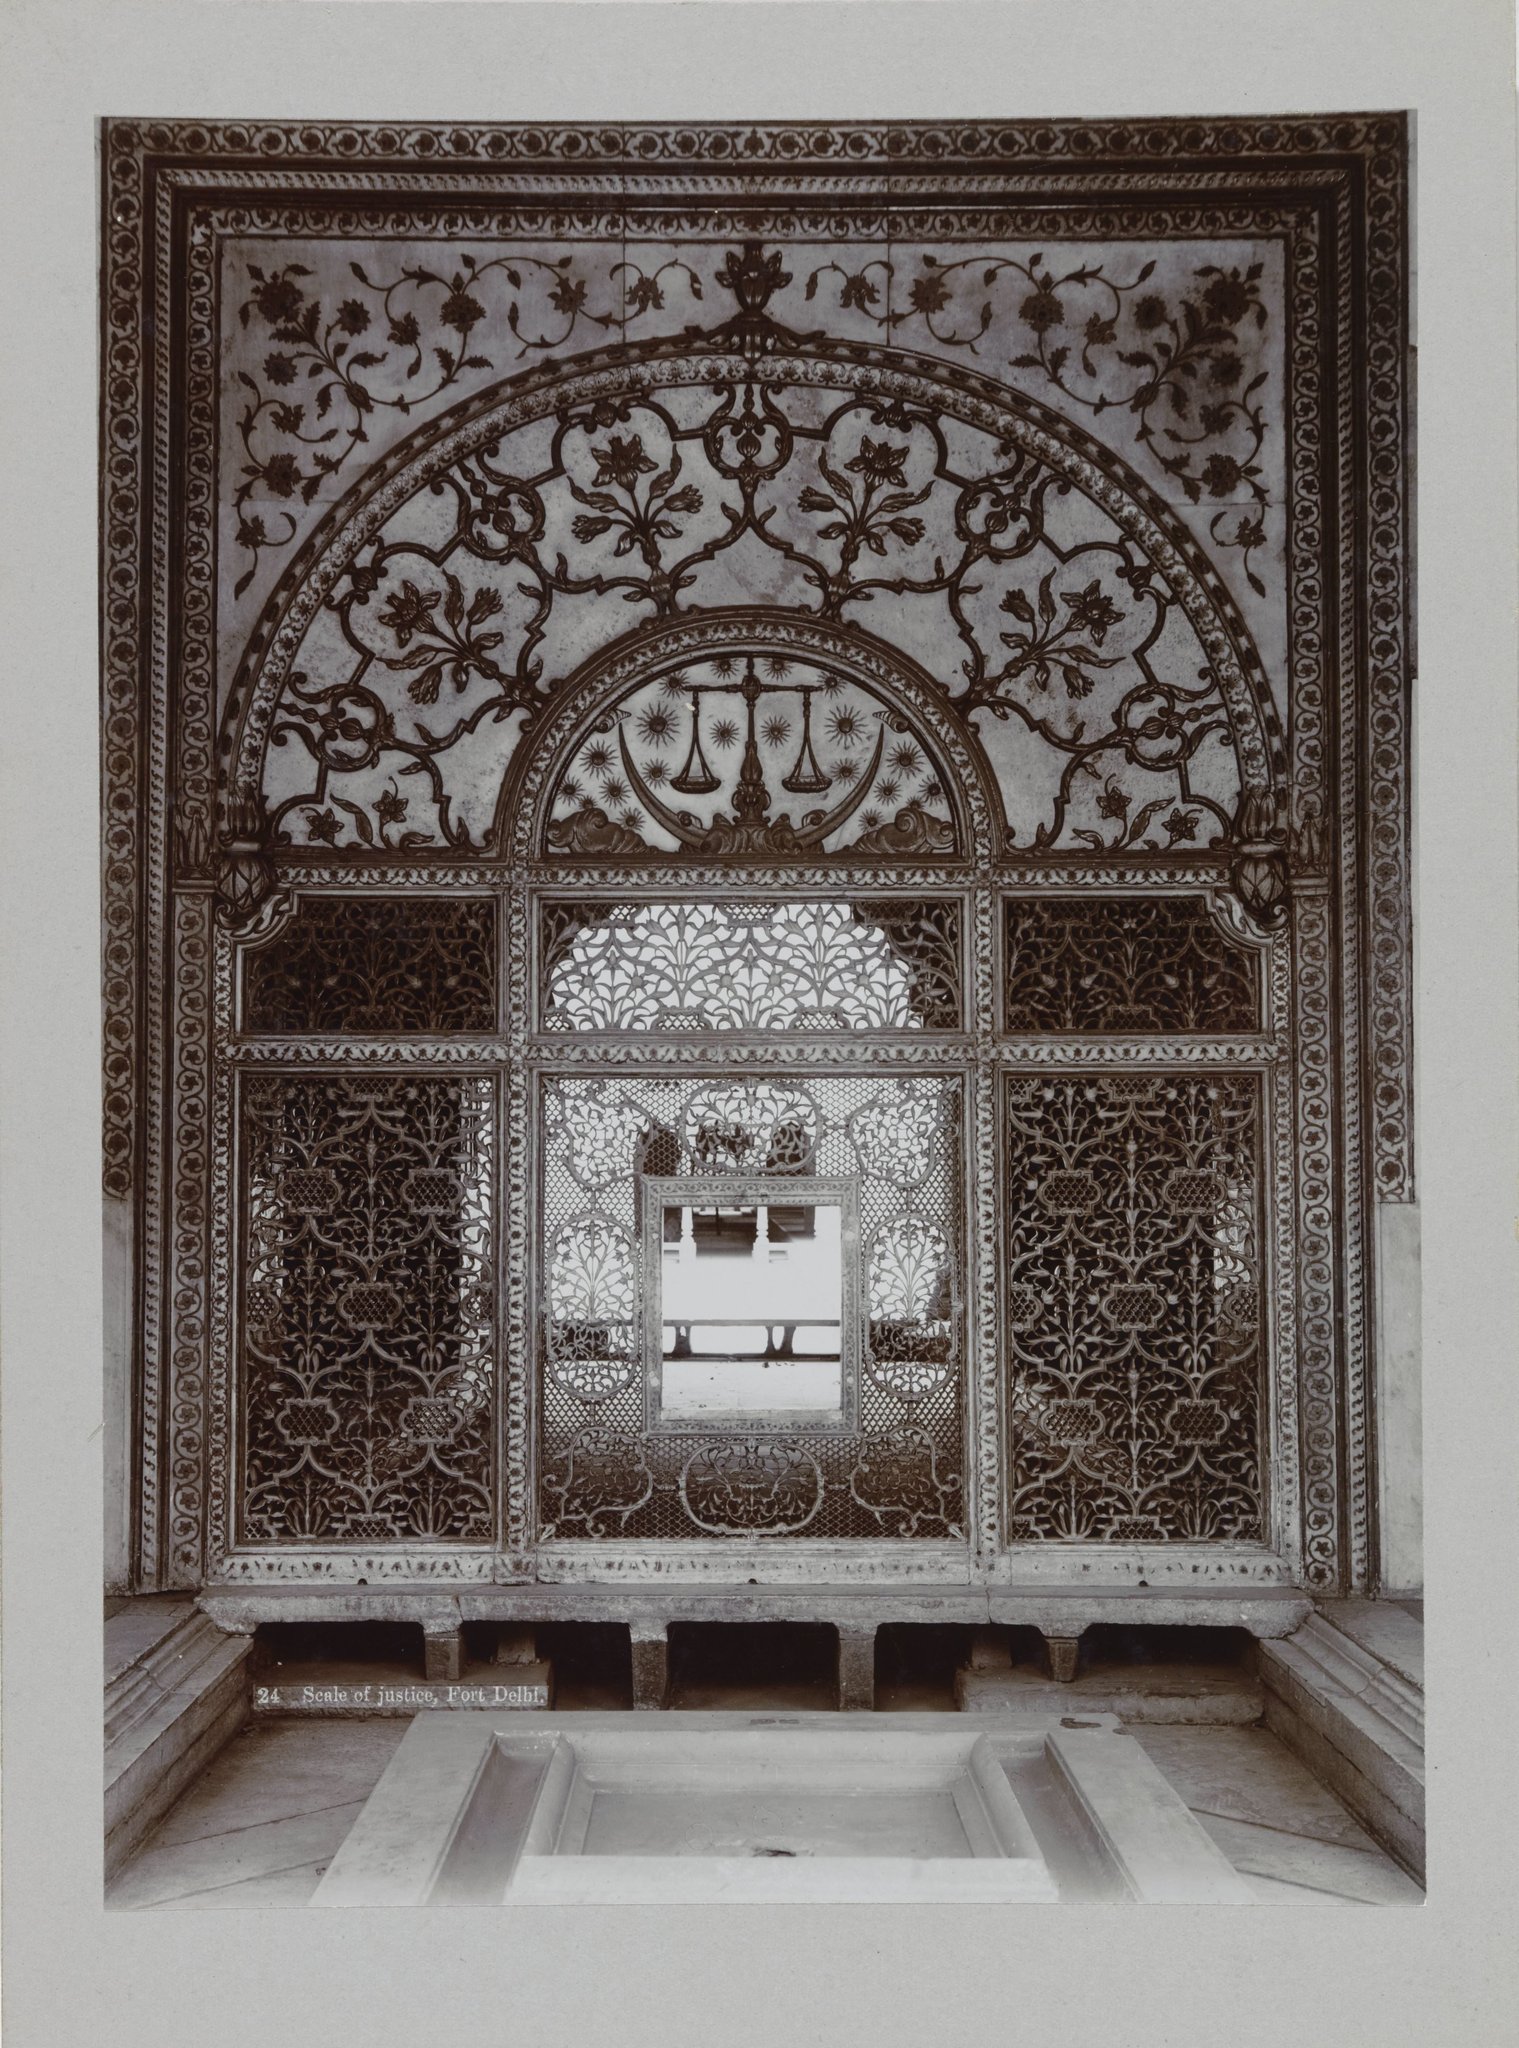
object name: photograph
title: Scale of Justice in the Khas Mahal within the Red Fort at Delhi, India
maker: Anonymous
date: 1895-1915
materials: cardboard, paper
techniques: gelatin silver print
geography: delhi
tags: delhi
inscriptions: inscription: ‘24 Scale of justice, Fort Delhi.’, number: ‘27.’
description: De Khas Mahal bevindt zich binnen het Rode Fort van Delhi.